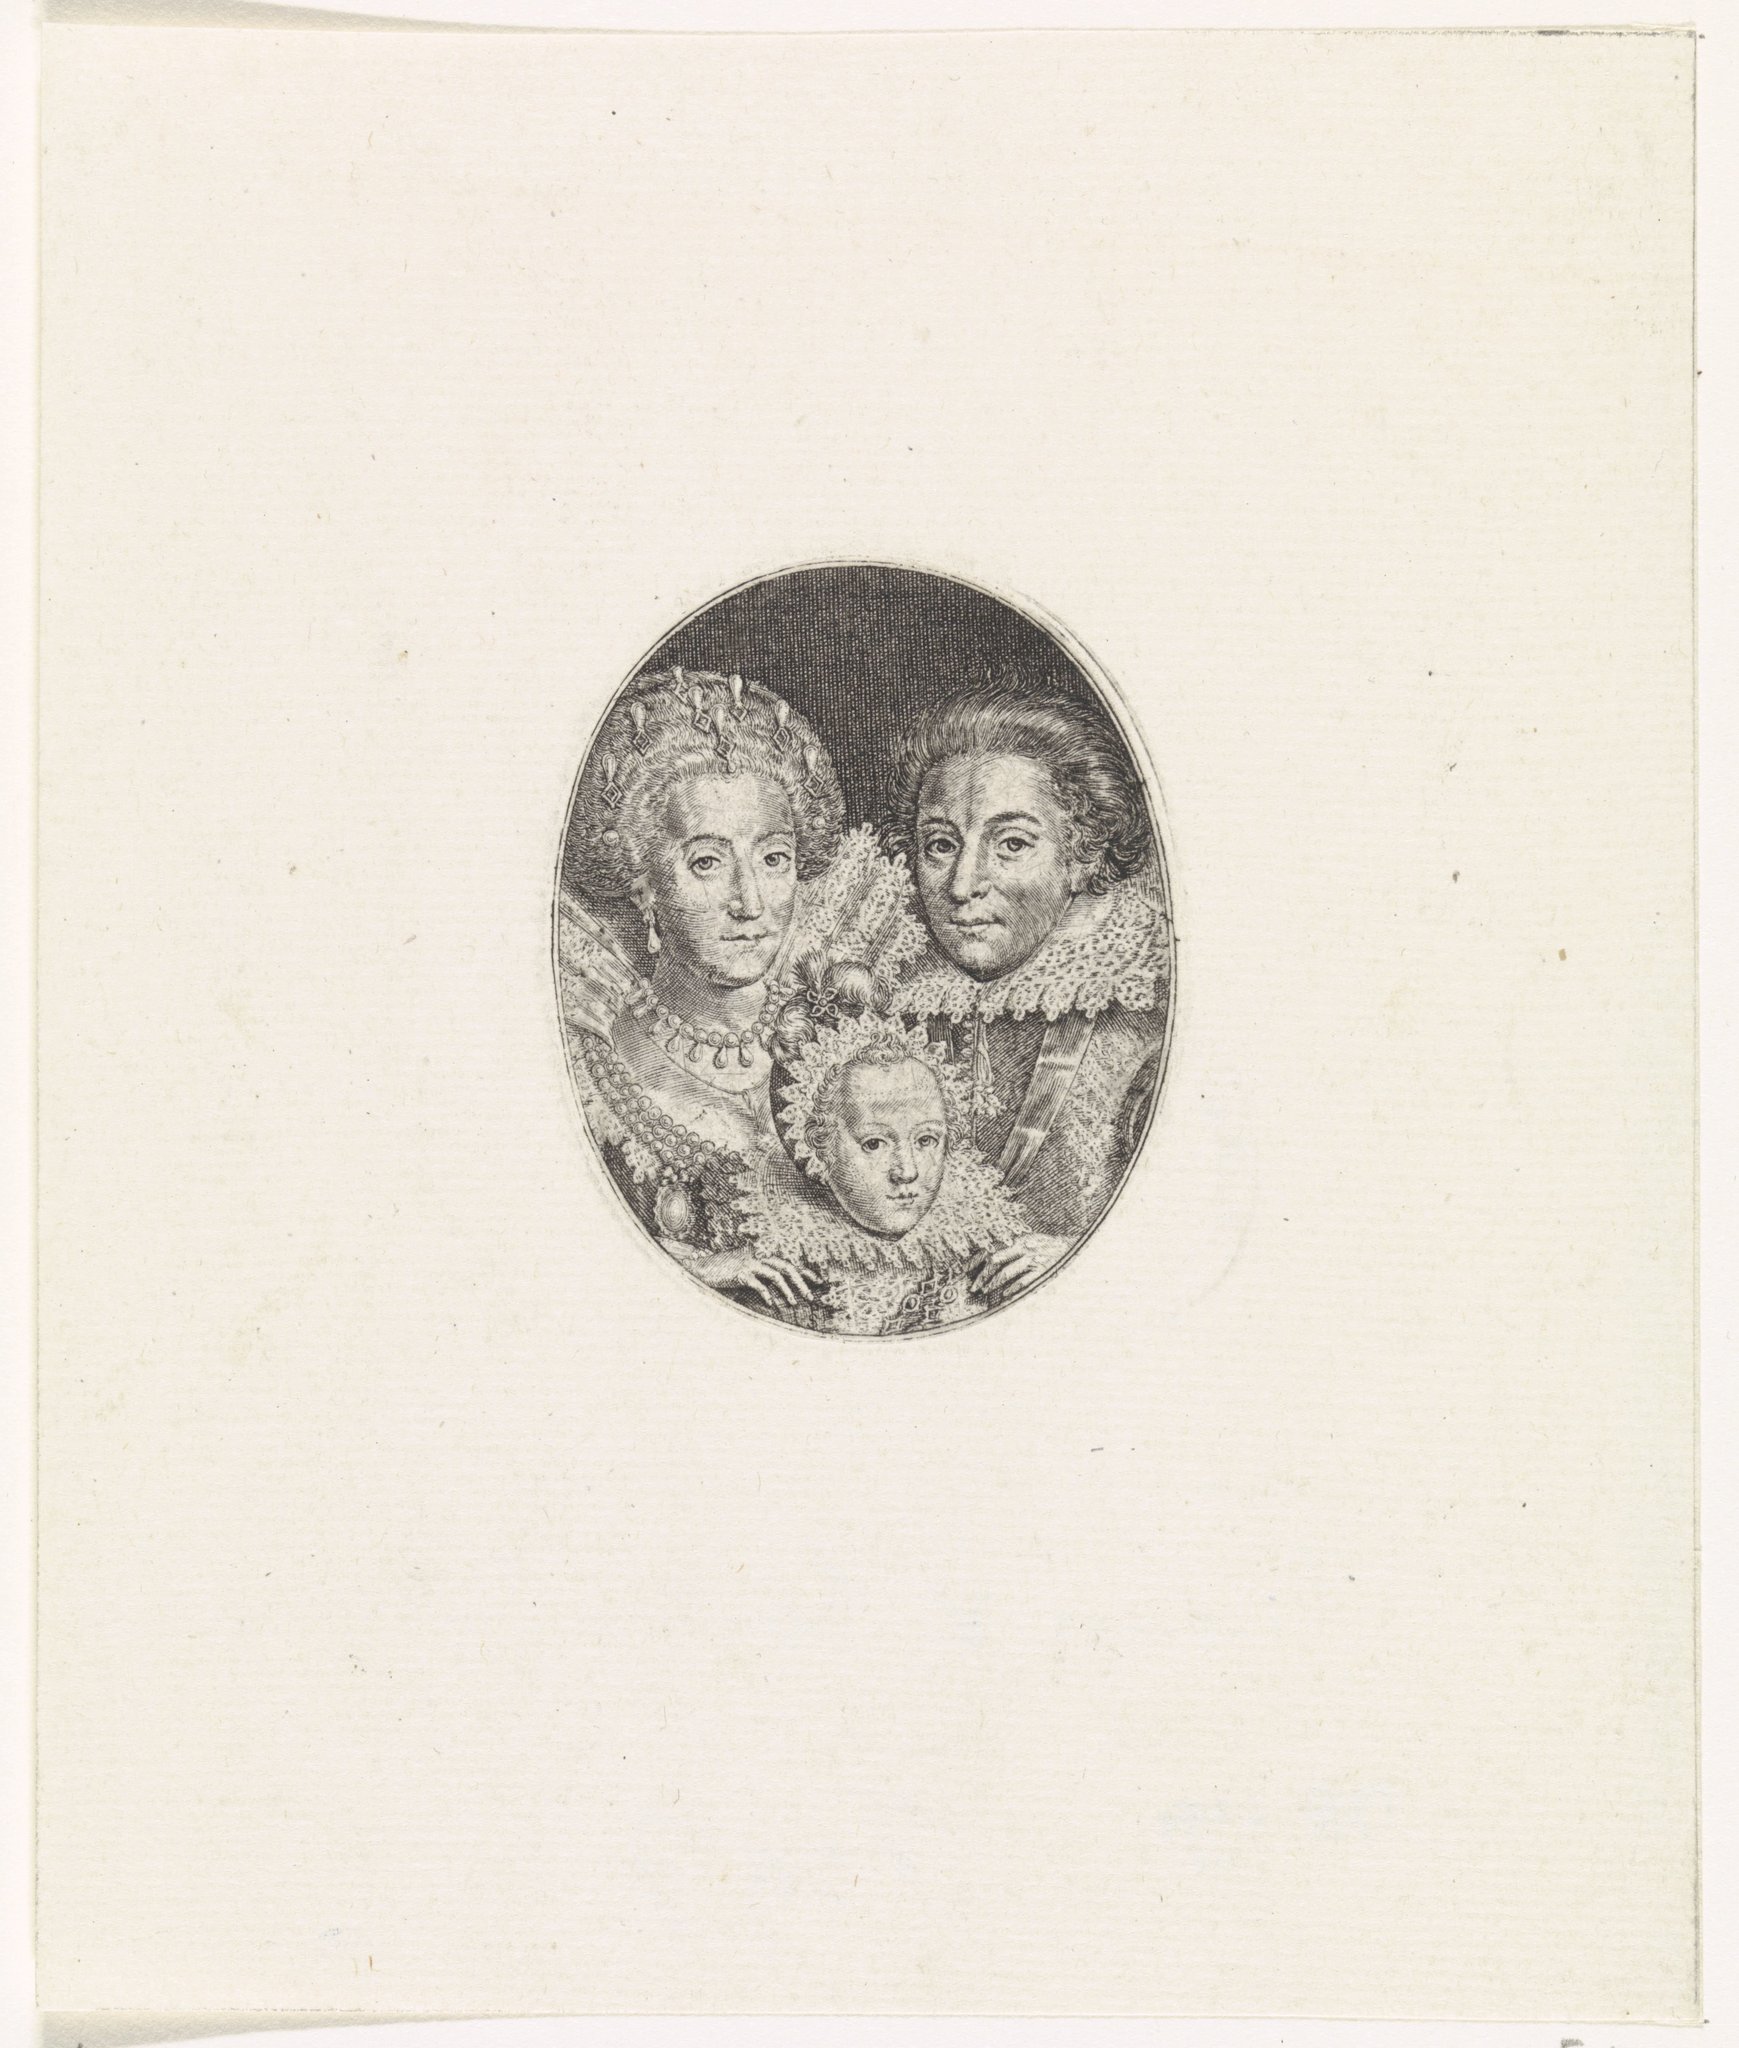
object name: print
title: Familieportret van Frederik V, zijn vrouw Elisabeth Stuart en hun zoon prins Frederik Hendrik van de Palts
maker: simon van de passe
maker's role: print maker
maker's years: 1595-1647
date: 1604-1647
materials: paper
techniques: engraving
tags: frederik v (keurvorst van de palts, koning van bohemen), london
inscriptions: collector's mark: Lugt 240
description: Het ontwerp van de prent is ook gebruikt voor een medaille (voorzijde).